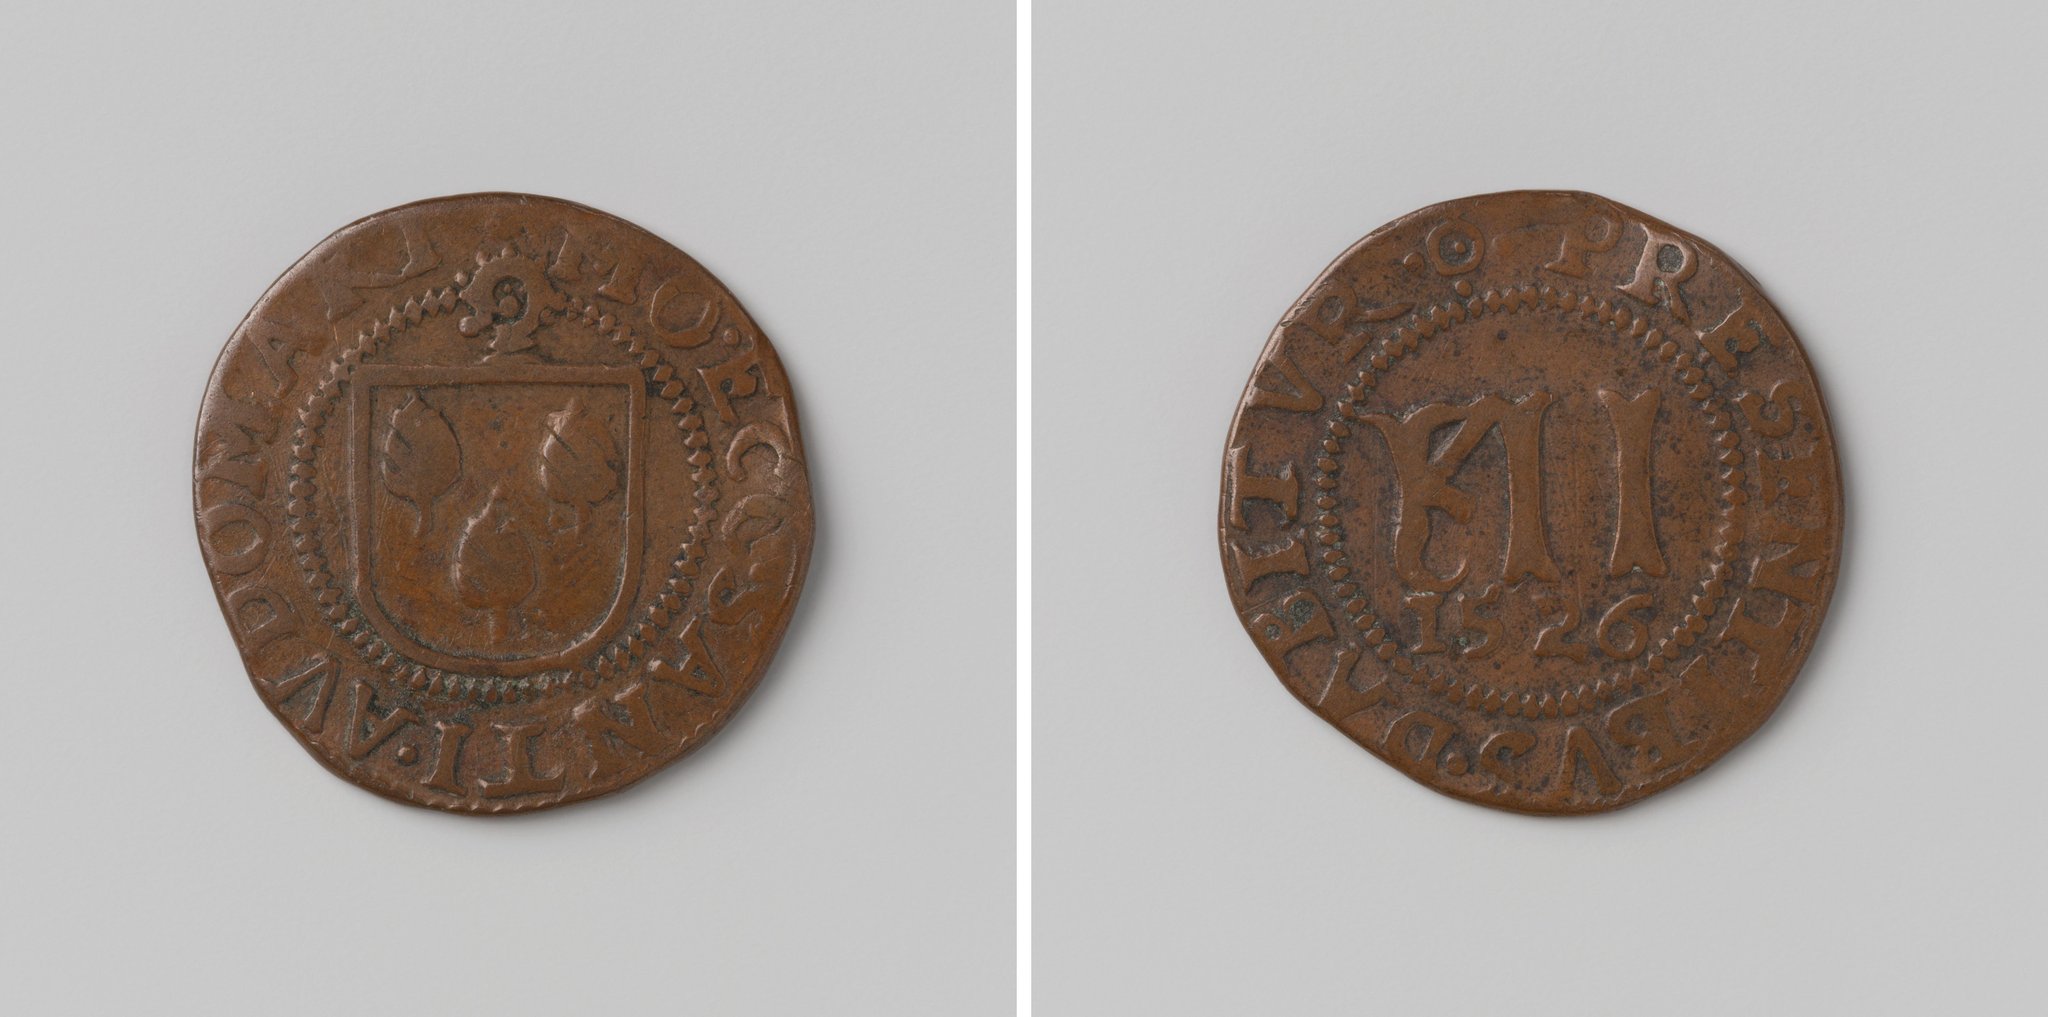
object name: devotional medal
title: Kerk van St. Omer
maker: Anonymous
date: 1526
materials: copper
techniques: striking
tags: saint-omer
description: Koperen penning. Voorzijde: wapenschild op bisschopsstaf binnen omschrift. Keerzijde: monogram boven jaartal binnen omschrift